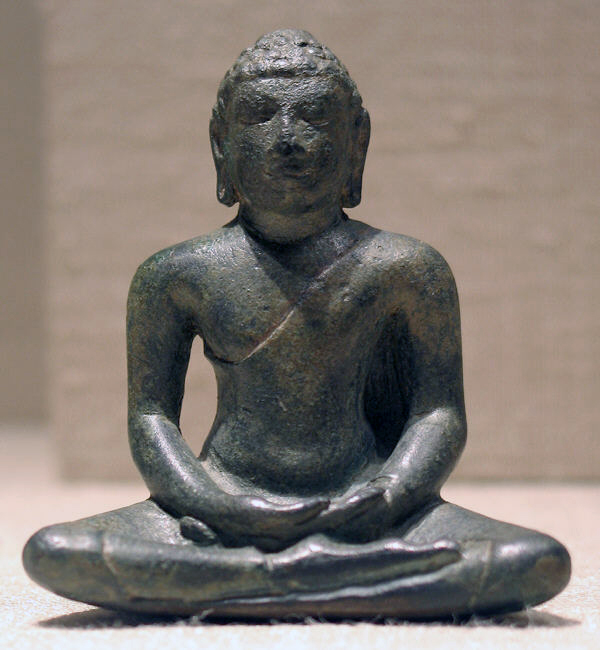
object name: figurine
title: Seated Buddha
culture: sri lankan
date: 667-700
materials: bronze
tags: buddhism,buddha